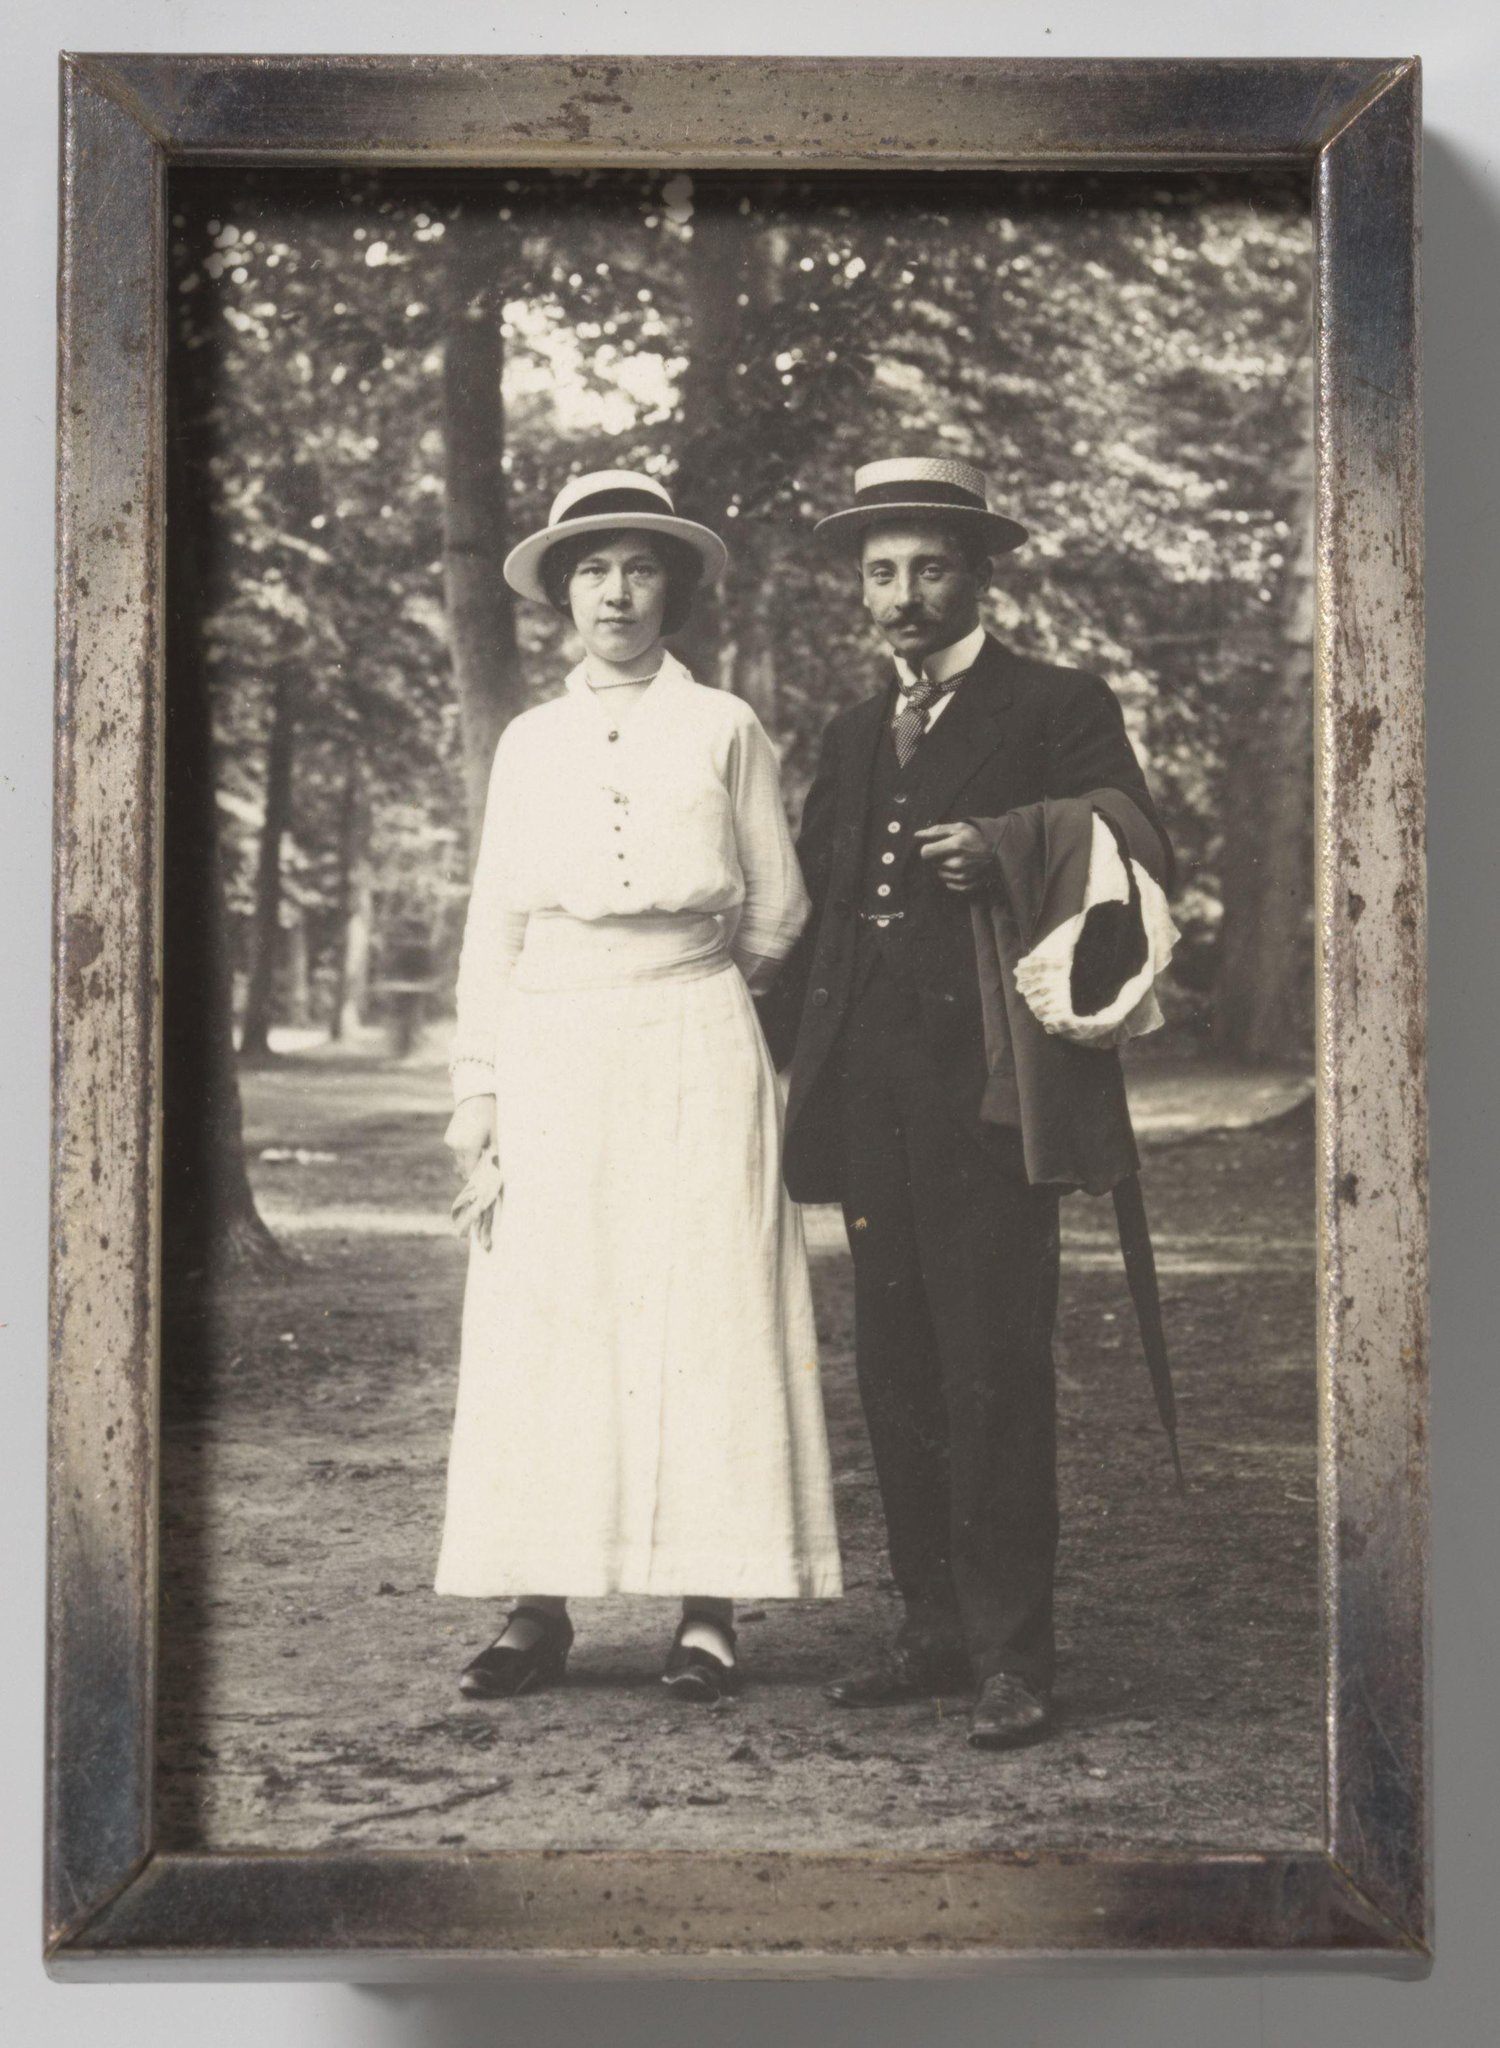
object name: frame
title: Portret van een onbekende man en vrouw in een bos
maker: Anonymous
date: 1890-1920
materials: paper, glass, metal, wood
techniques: gelatin silver print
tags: forest, wood, anonymous historical person portrayed, couple of lovers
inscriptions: inscription: ‘ARCO Made in England’, inscription: ‘Pat. 171605’